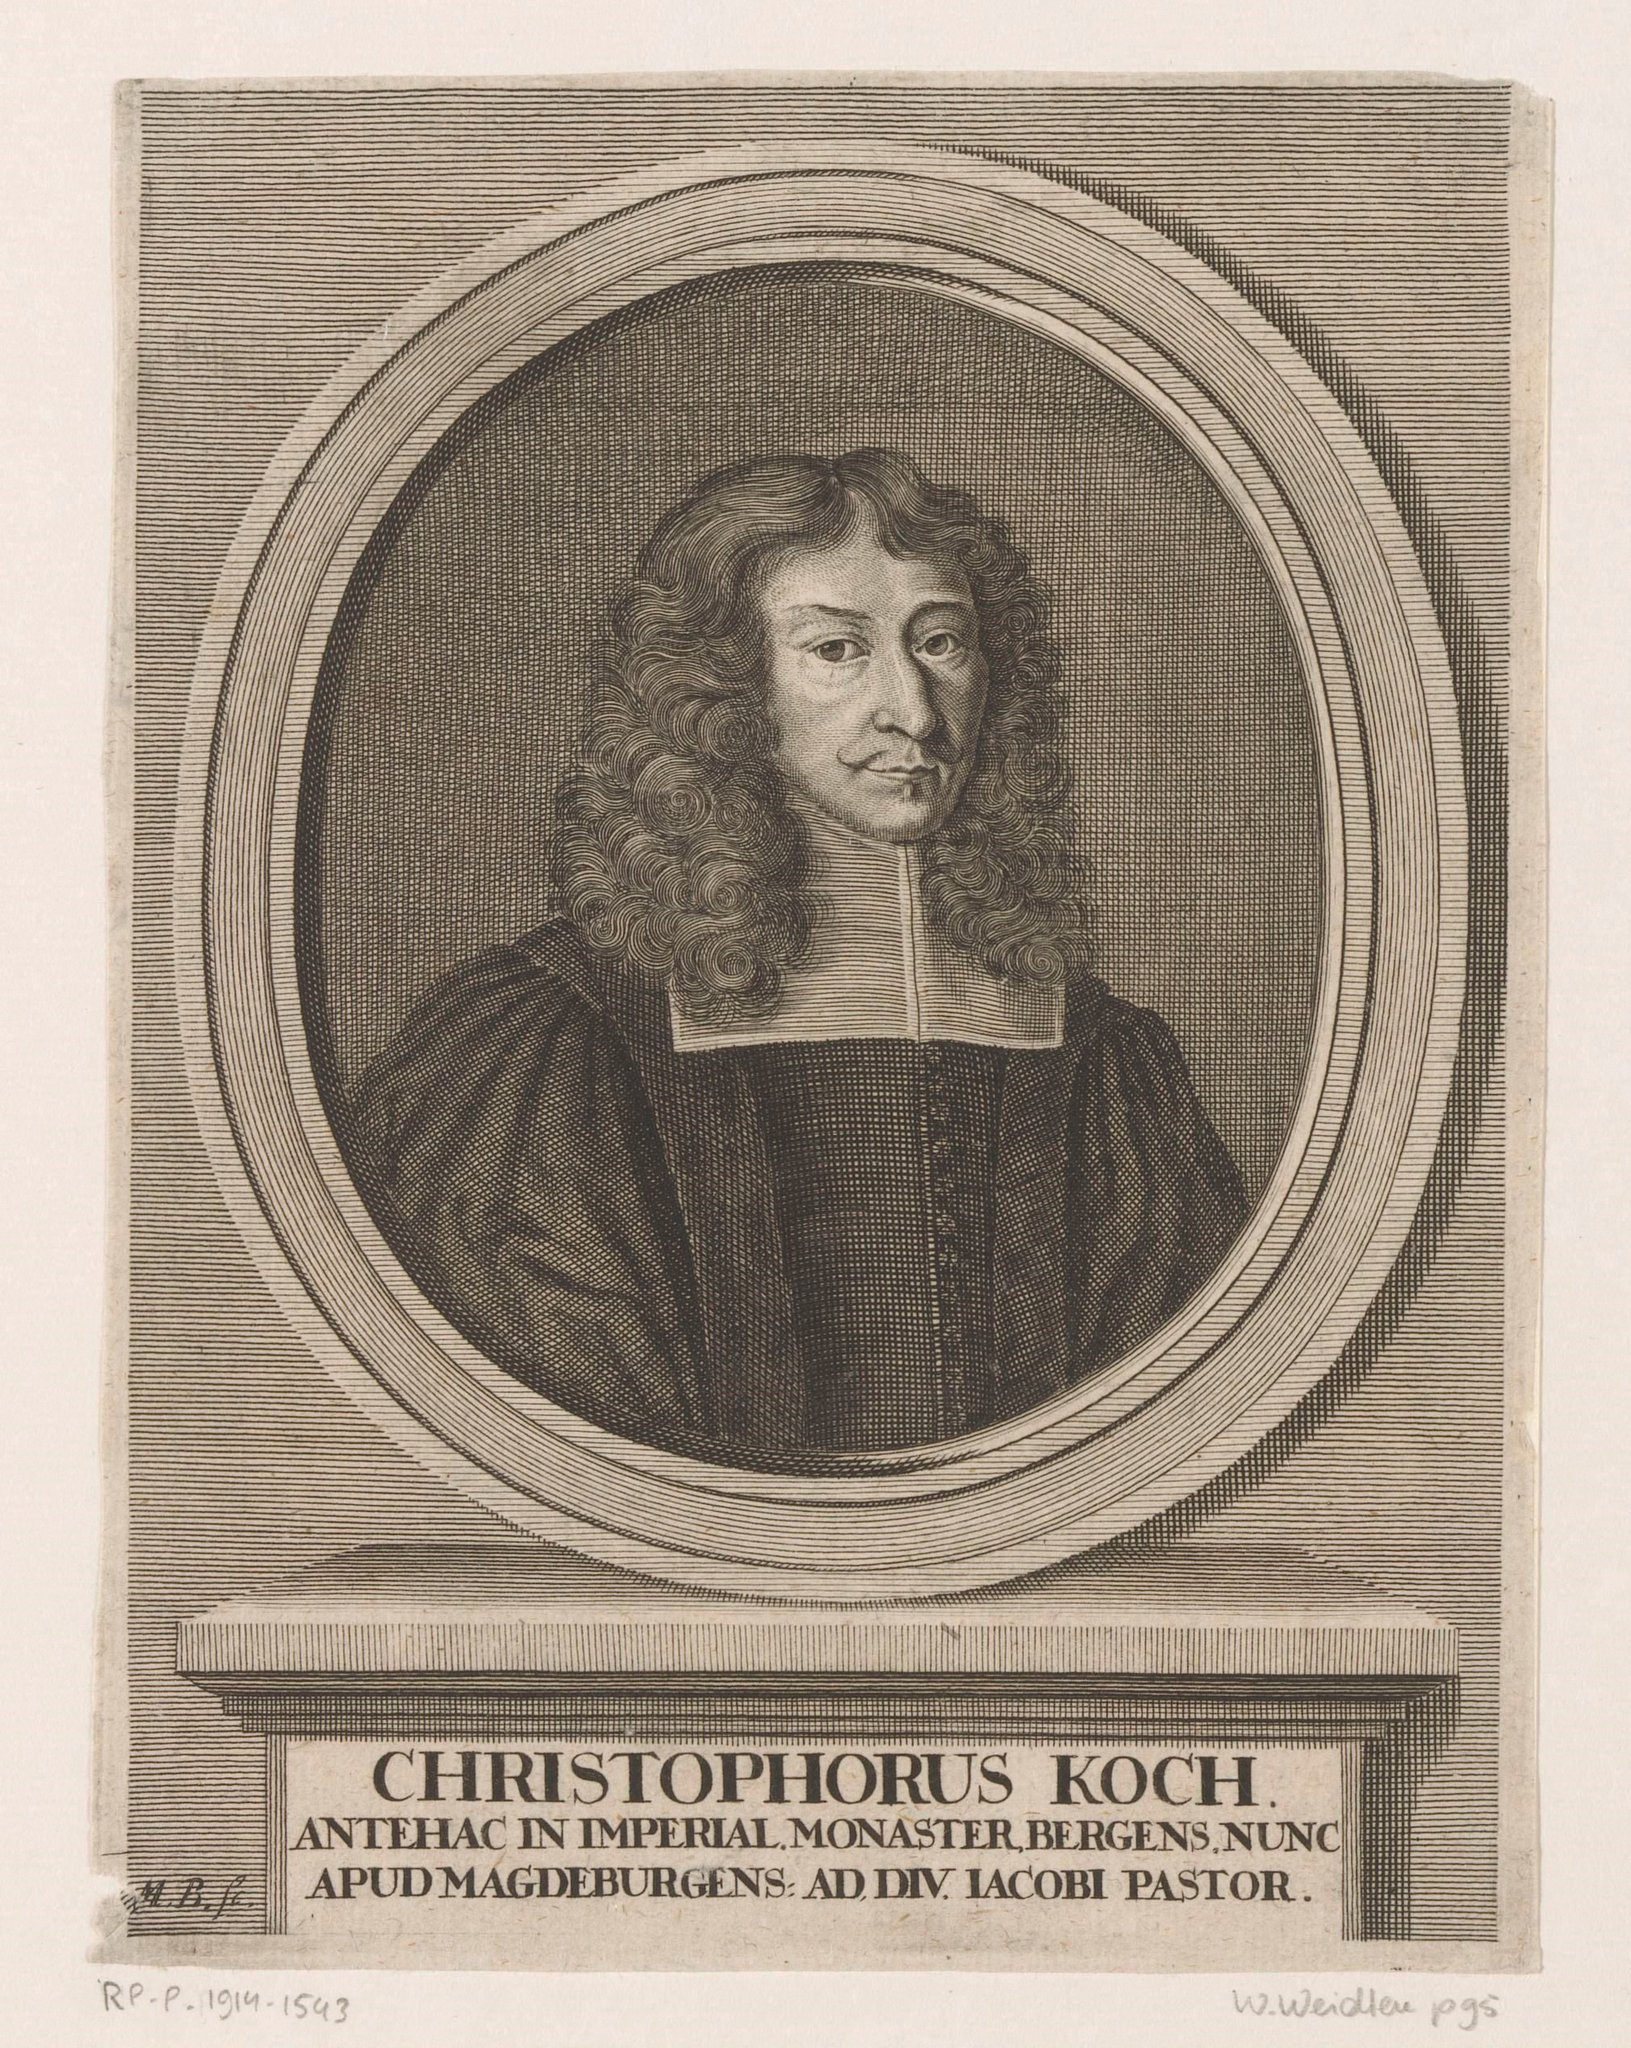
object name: print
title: Portret van Christoph Koch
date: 1690-1733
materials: paper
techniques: engraving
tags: historical persons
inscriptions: collector's mark: Lugt 2228